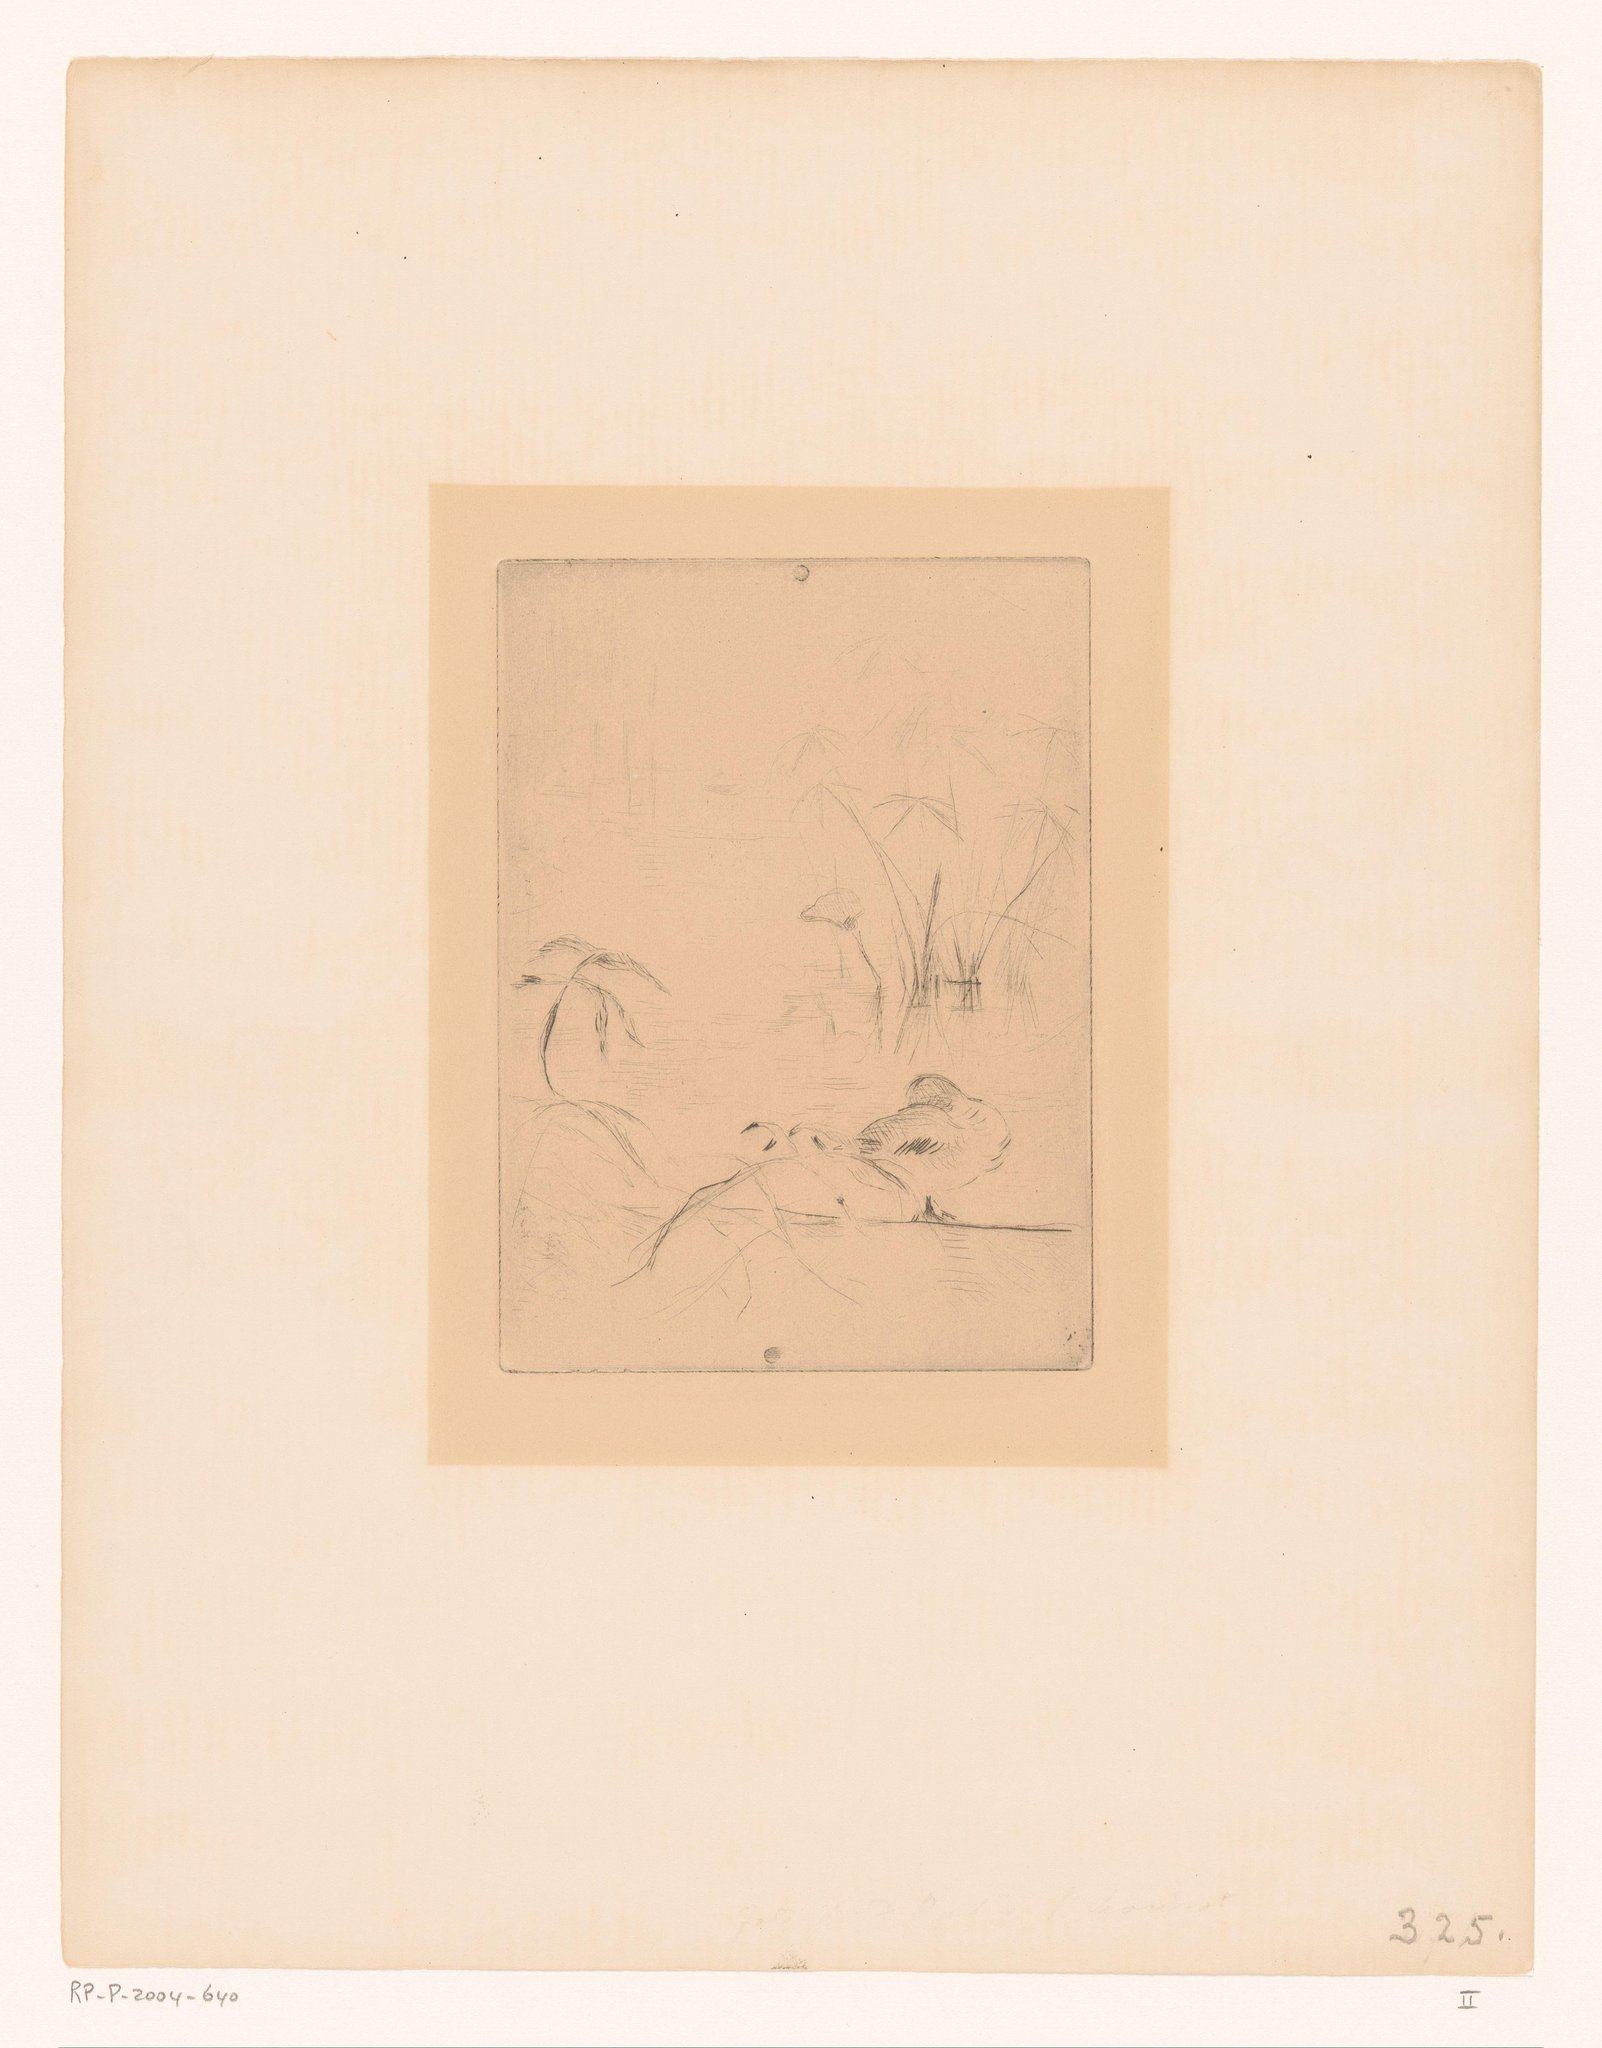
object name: print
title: Rustende eend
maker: berthe morisot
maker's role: print maker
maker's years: 1841-1895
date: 1889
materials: paper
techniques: drypoint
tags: water-birds: duck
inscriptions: collector's mark: Lugt 2228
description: De prenten van Morisot werden voor het eerst tussen 1888-1890 gedrukt. Een eerste herdruk als serie door Ernst Rouart vond plaats tussen 1904-1905. De tweede herdruk vond plaats in 1921 en de derde en laatste herdruk rond 1930 door de uitgever Vollard en de drukker Fort die de serie annuleerde aan de hand van gaten aan de boven- en onderkant van de plaat. Zie British Museum, inv.nr. 1949,0411.2578.